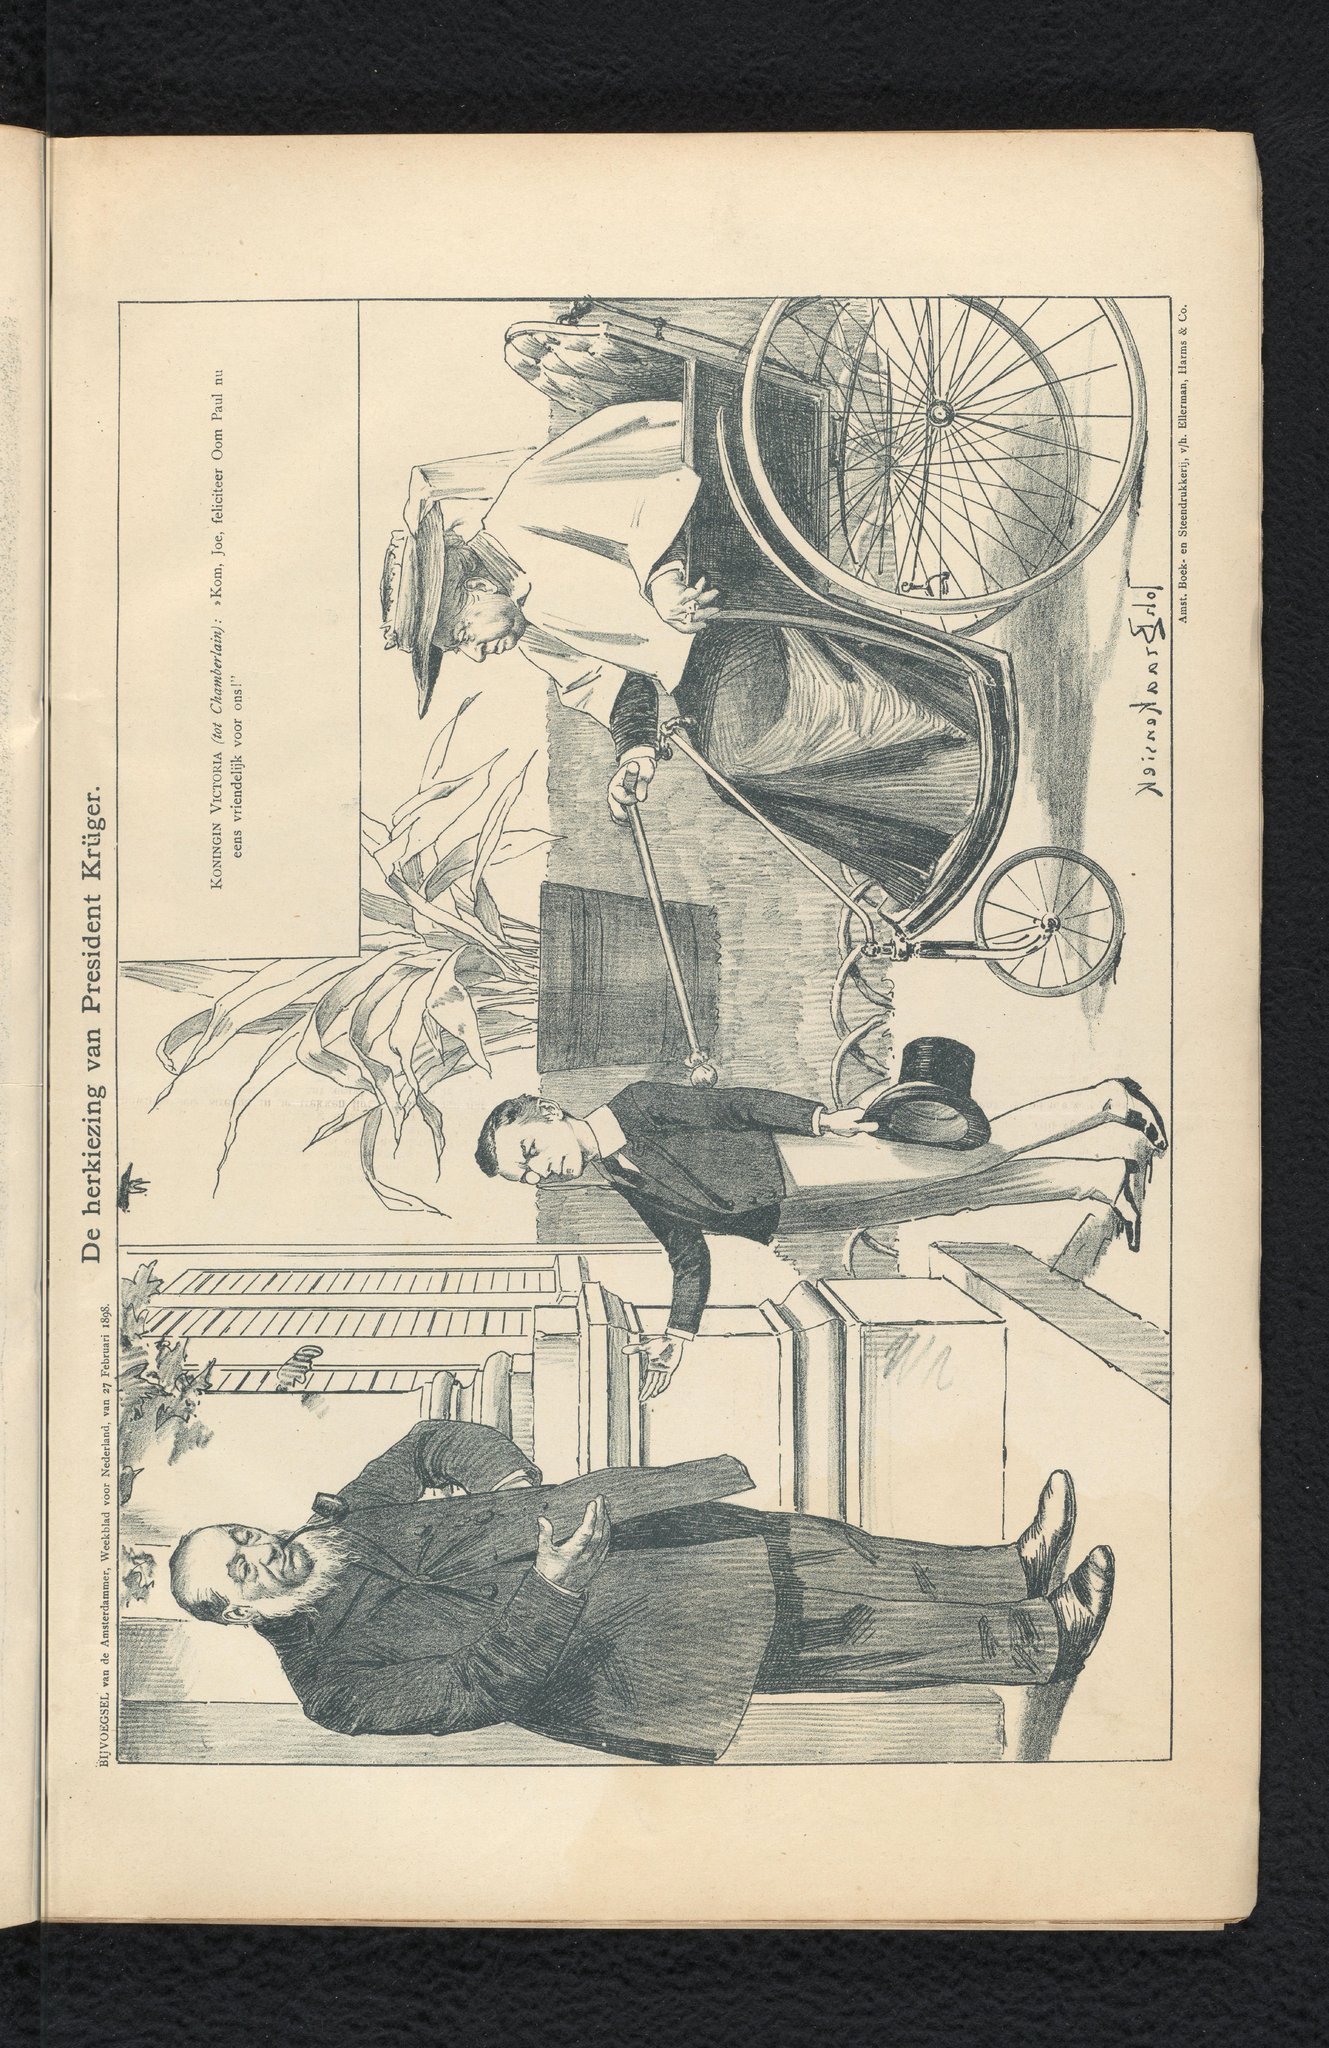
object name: cartoon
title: De herkiezing van president Krüger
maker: johan braakensiek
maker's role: draughtsman, print maker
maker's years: 1858-1940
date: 1898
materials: paper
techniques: lithograph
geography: amsterdam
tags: victoria (koningin van het verenigd koninkrijk en keizerin van india), shaking hands, 'dextrarum junctio', personifications of countries, nations, states, districts, etc., wheelchair, bathchair - aa - female human figure, political caricatures and satires, election, choice of a ruler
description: Koningin Victoria, in rolstoel, laat de jongen Joseph Chamberlain Paul Kruger feliciteren met zijn herkiezing als president van de Zuid-Afrikaansche Republiek Transvaal.